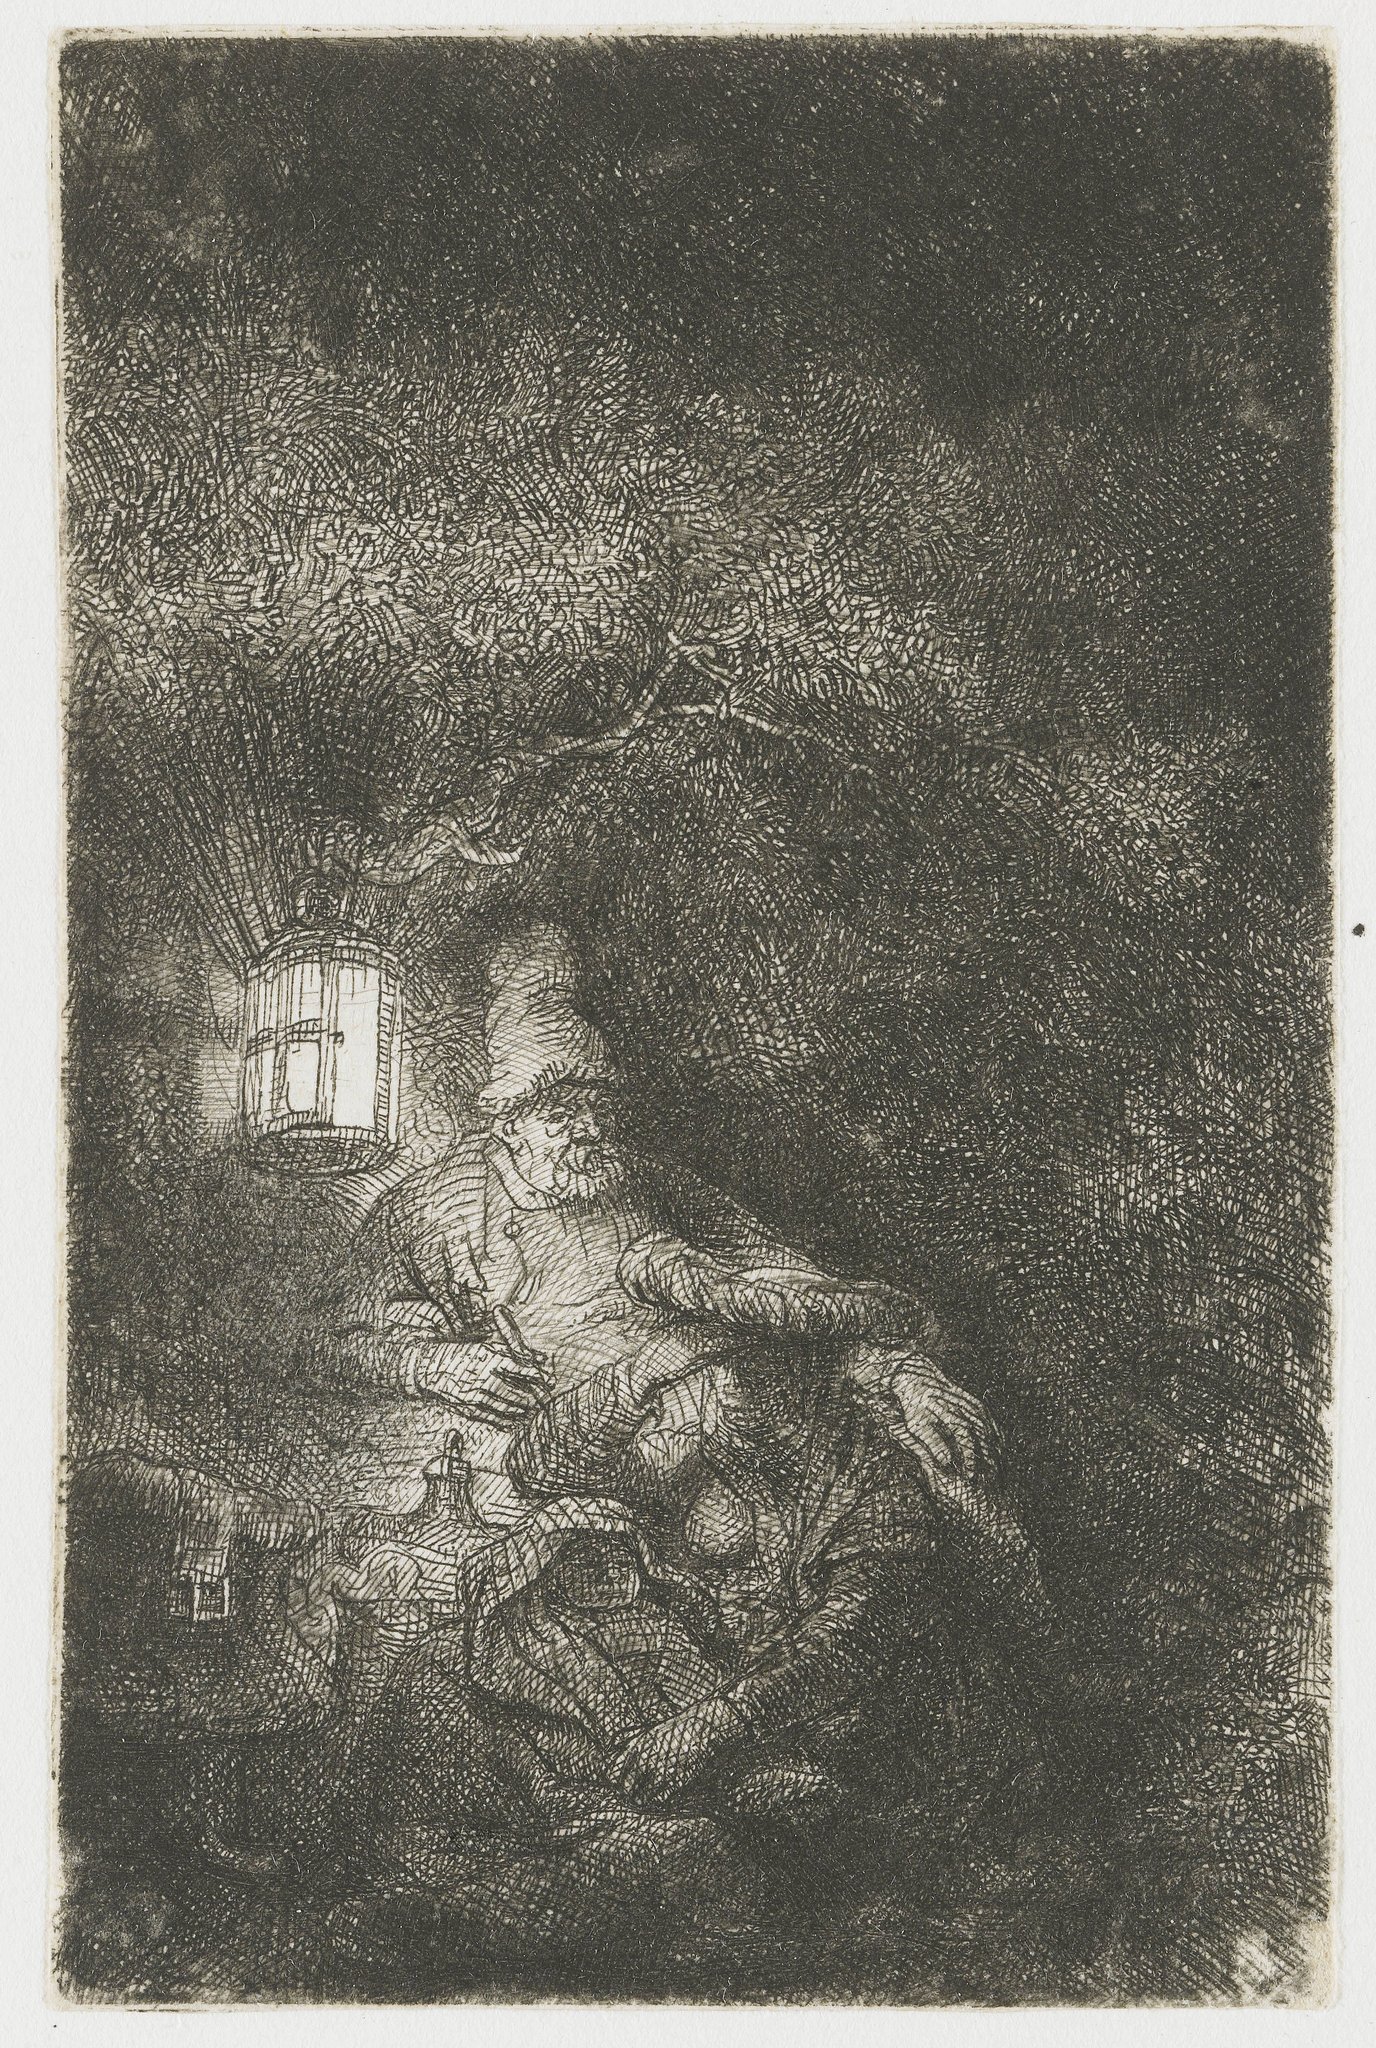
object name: print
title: The rest on the flight into Egypt: a night piece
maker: rembrandt van rijn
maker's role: draughtsman, painter, print maker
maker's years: 1606-1669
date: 1644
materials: paper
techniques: drypoint, etching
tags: rest on the flight into egypt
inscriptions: collector's mark: Lugt 240